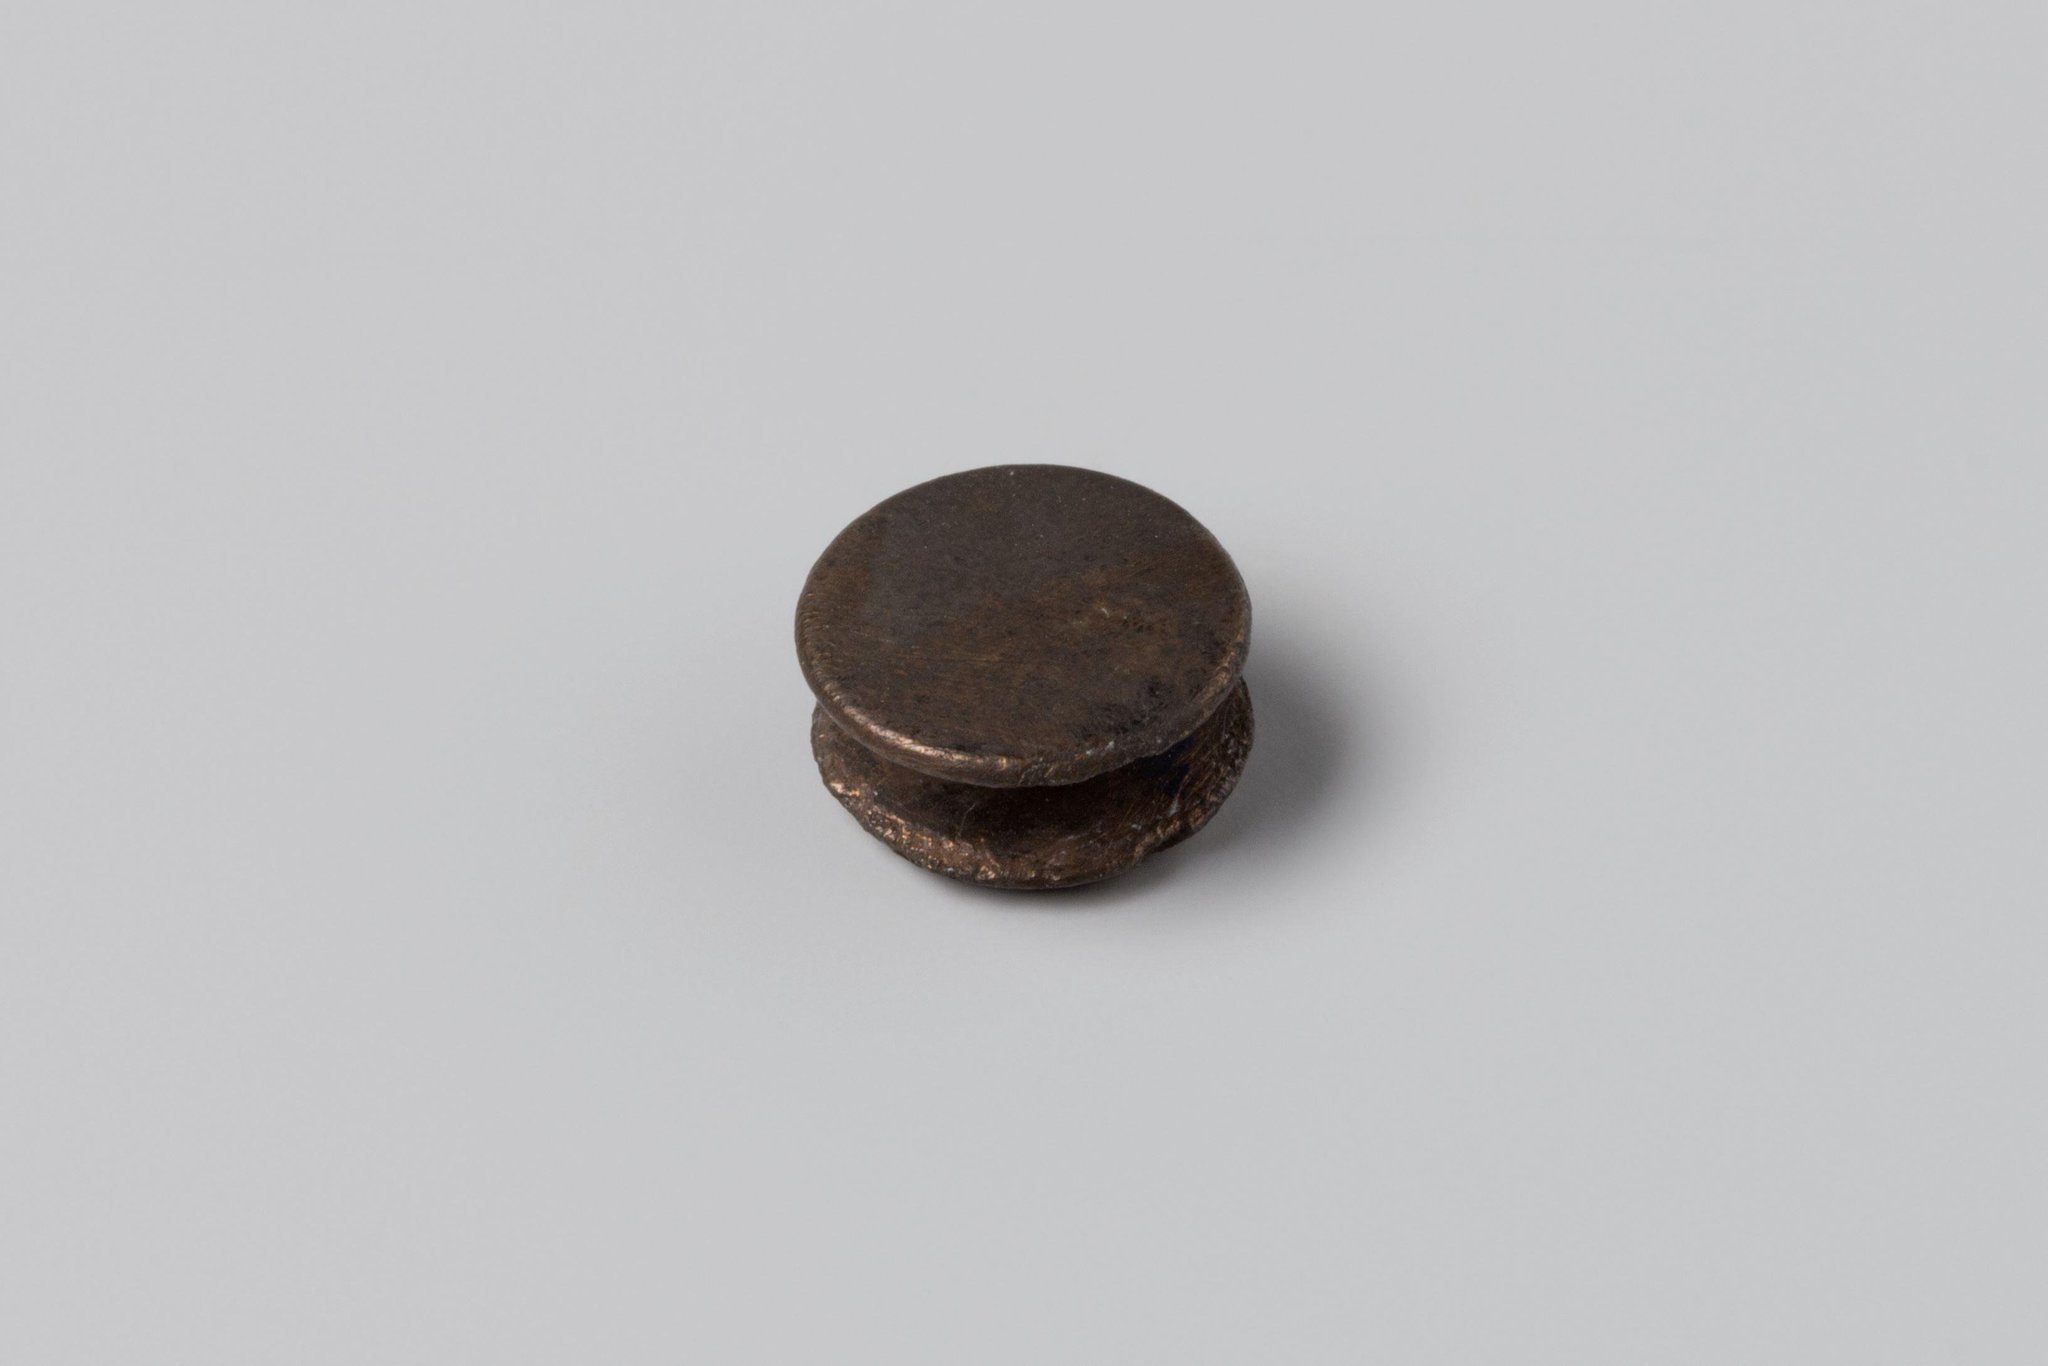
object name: collar button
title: Boordeknoopje uit het wrak van de Oost-Indiëvaarder Hollandia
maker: Anonymous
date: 1700-1743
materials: copper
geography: netherlands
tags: verenigde oostindische compagnie, hollandia (schip), annet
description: Boordeknoop. Stud; (1) flat, circular top (1.1d), plain.